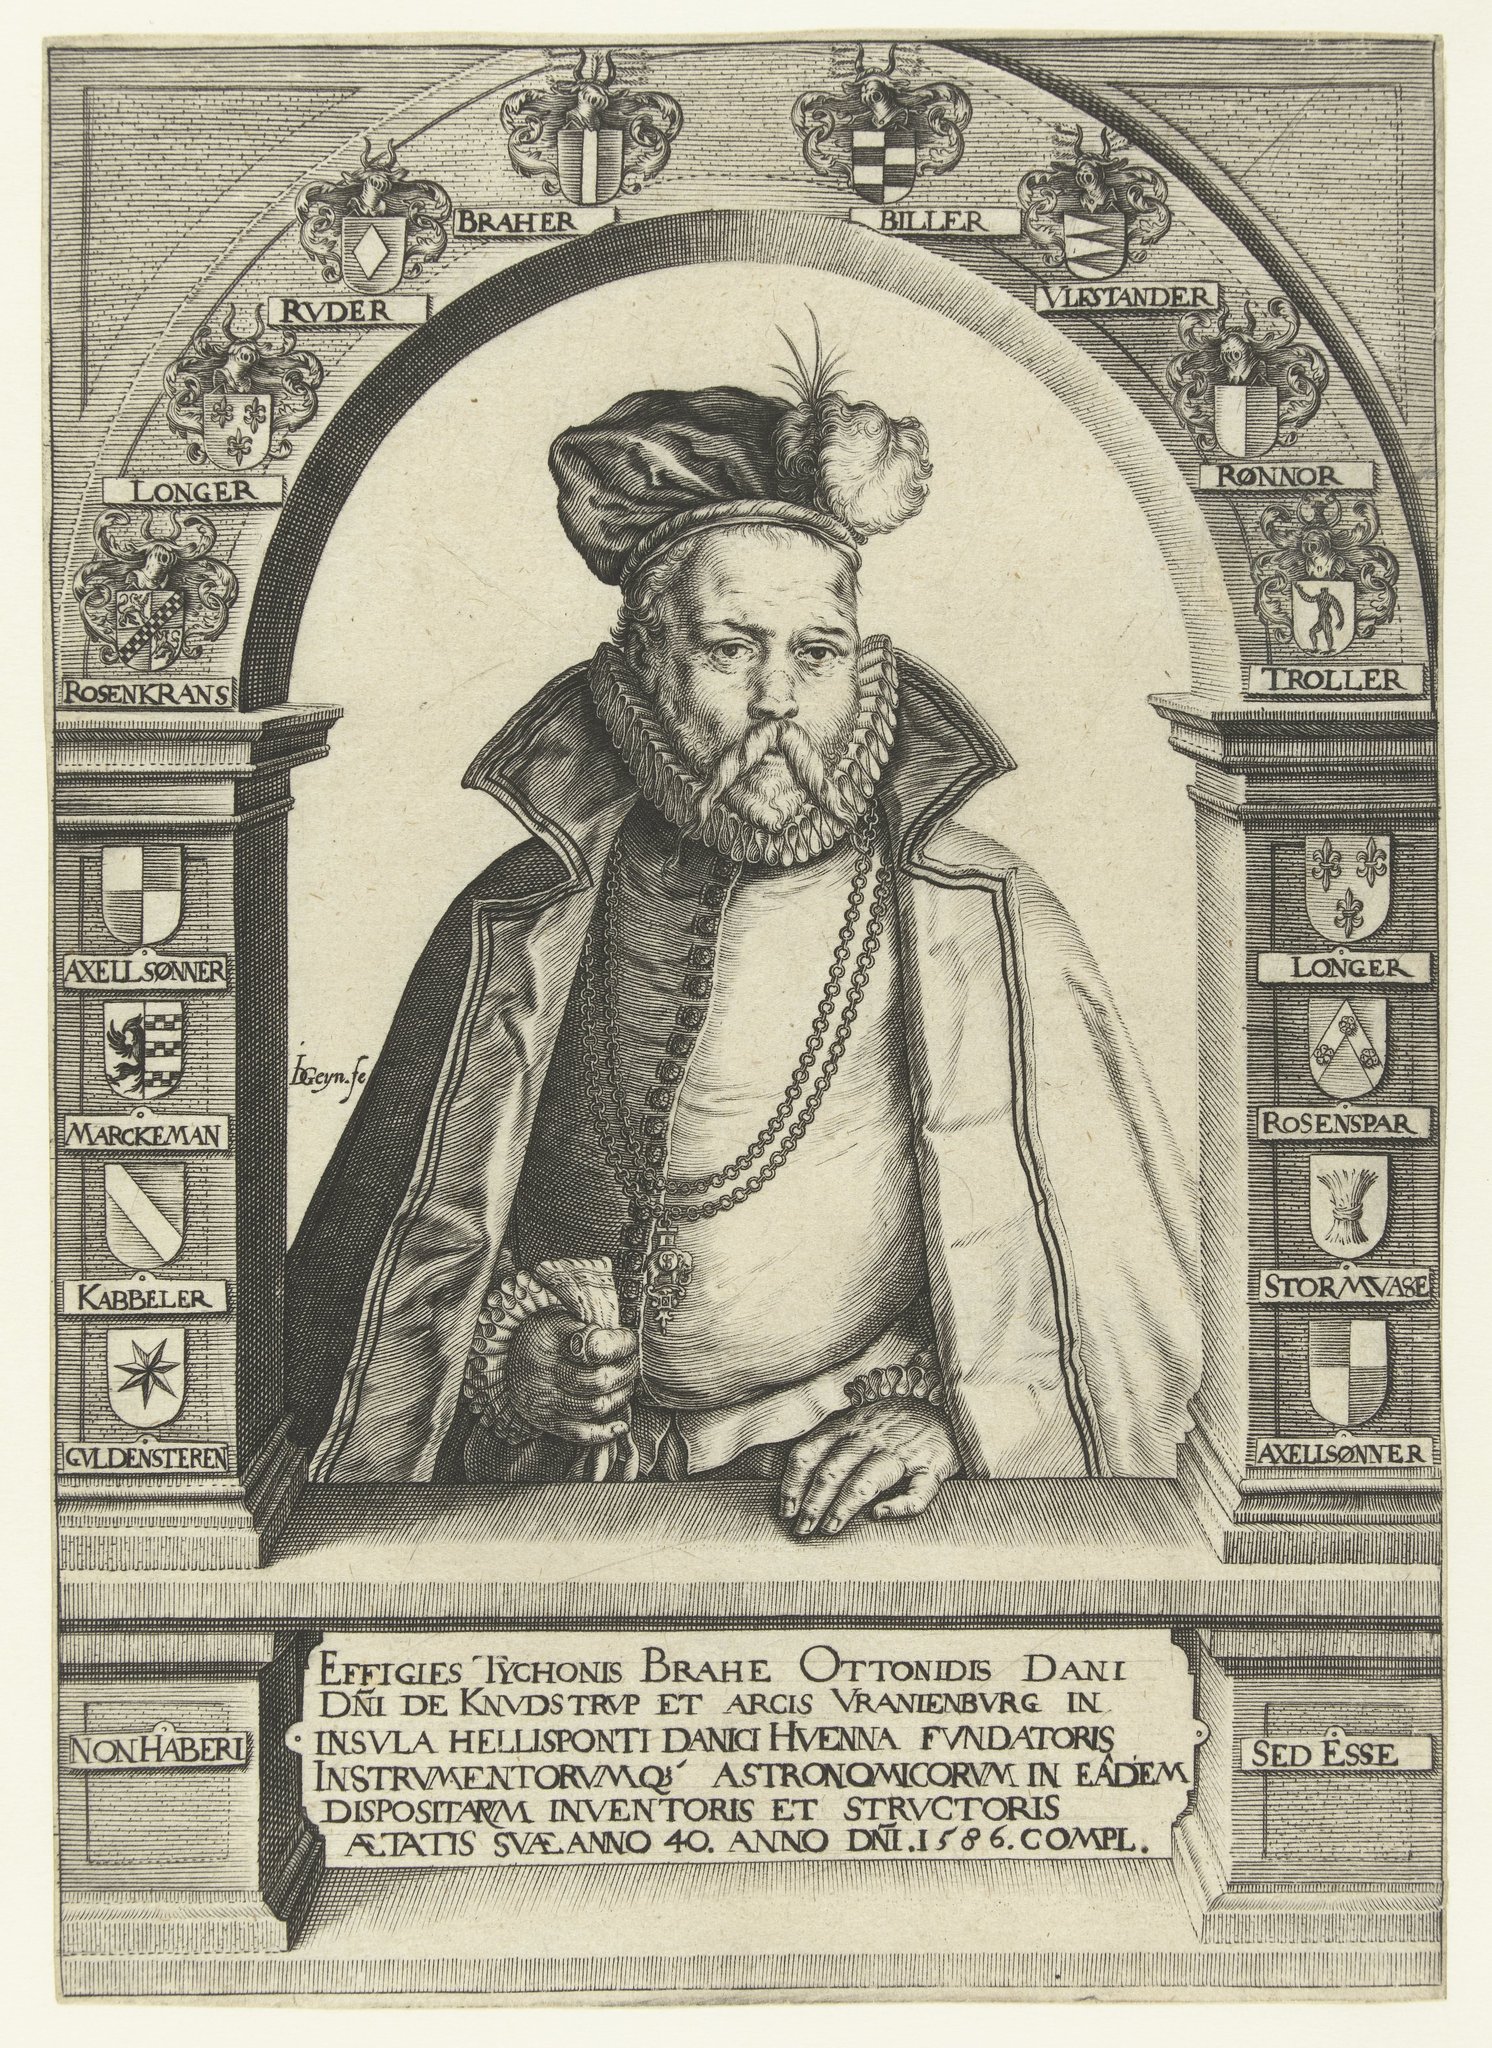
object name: print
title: Portret van Tycho Brahe op veertigjarige leeftijd (met muts)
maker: jacques de gheyn (ii)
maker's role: painter, print maker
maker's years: 1565-1629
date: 1593-1597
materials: paper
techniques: engraving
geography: netherlands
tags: prague, tycho brahe, head-gear, gloves, mittens, etc., coat (+ men's clothes), historical persons, armorial bearing, heraldry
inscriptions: collector's mark: Lugt 2773, collector's mark: Lugt 2228a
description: Tycho Brahe op veertigjarige leeftijd, ten halven lijve, van voren gezien, in een boogvormige nis, gekleed in mantel met opstaande kraag, waaronder een geplooide kraag. Ketting om de hals, handschoen(en) in de rechterhand, muts op het hoofd. Op de boogvormige nis verschillende wapens met familienamen erbij. Latijns onderschrift in cartouche. Aan weerszijden van de cartouche het motto 'Non Haberi Sed Esse'.